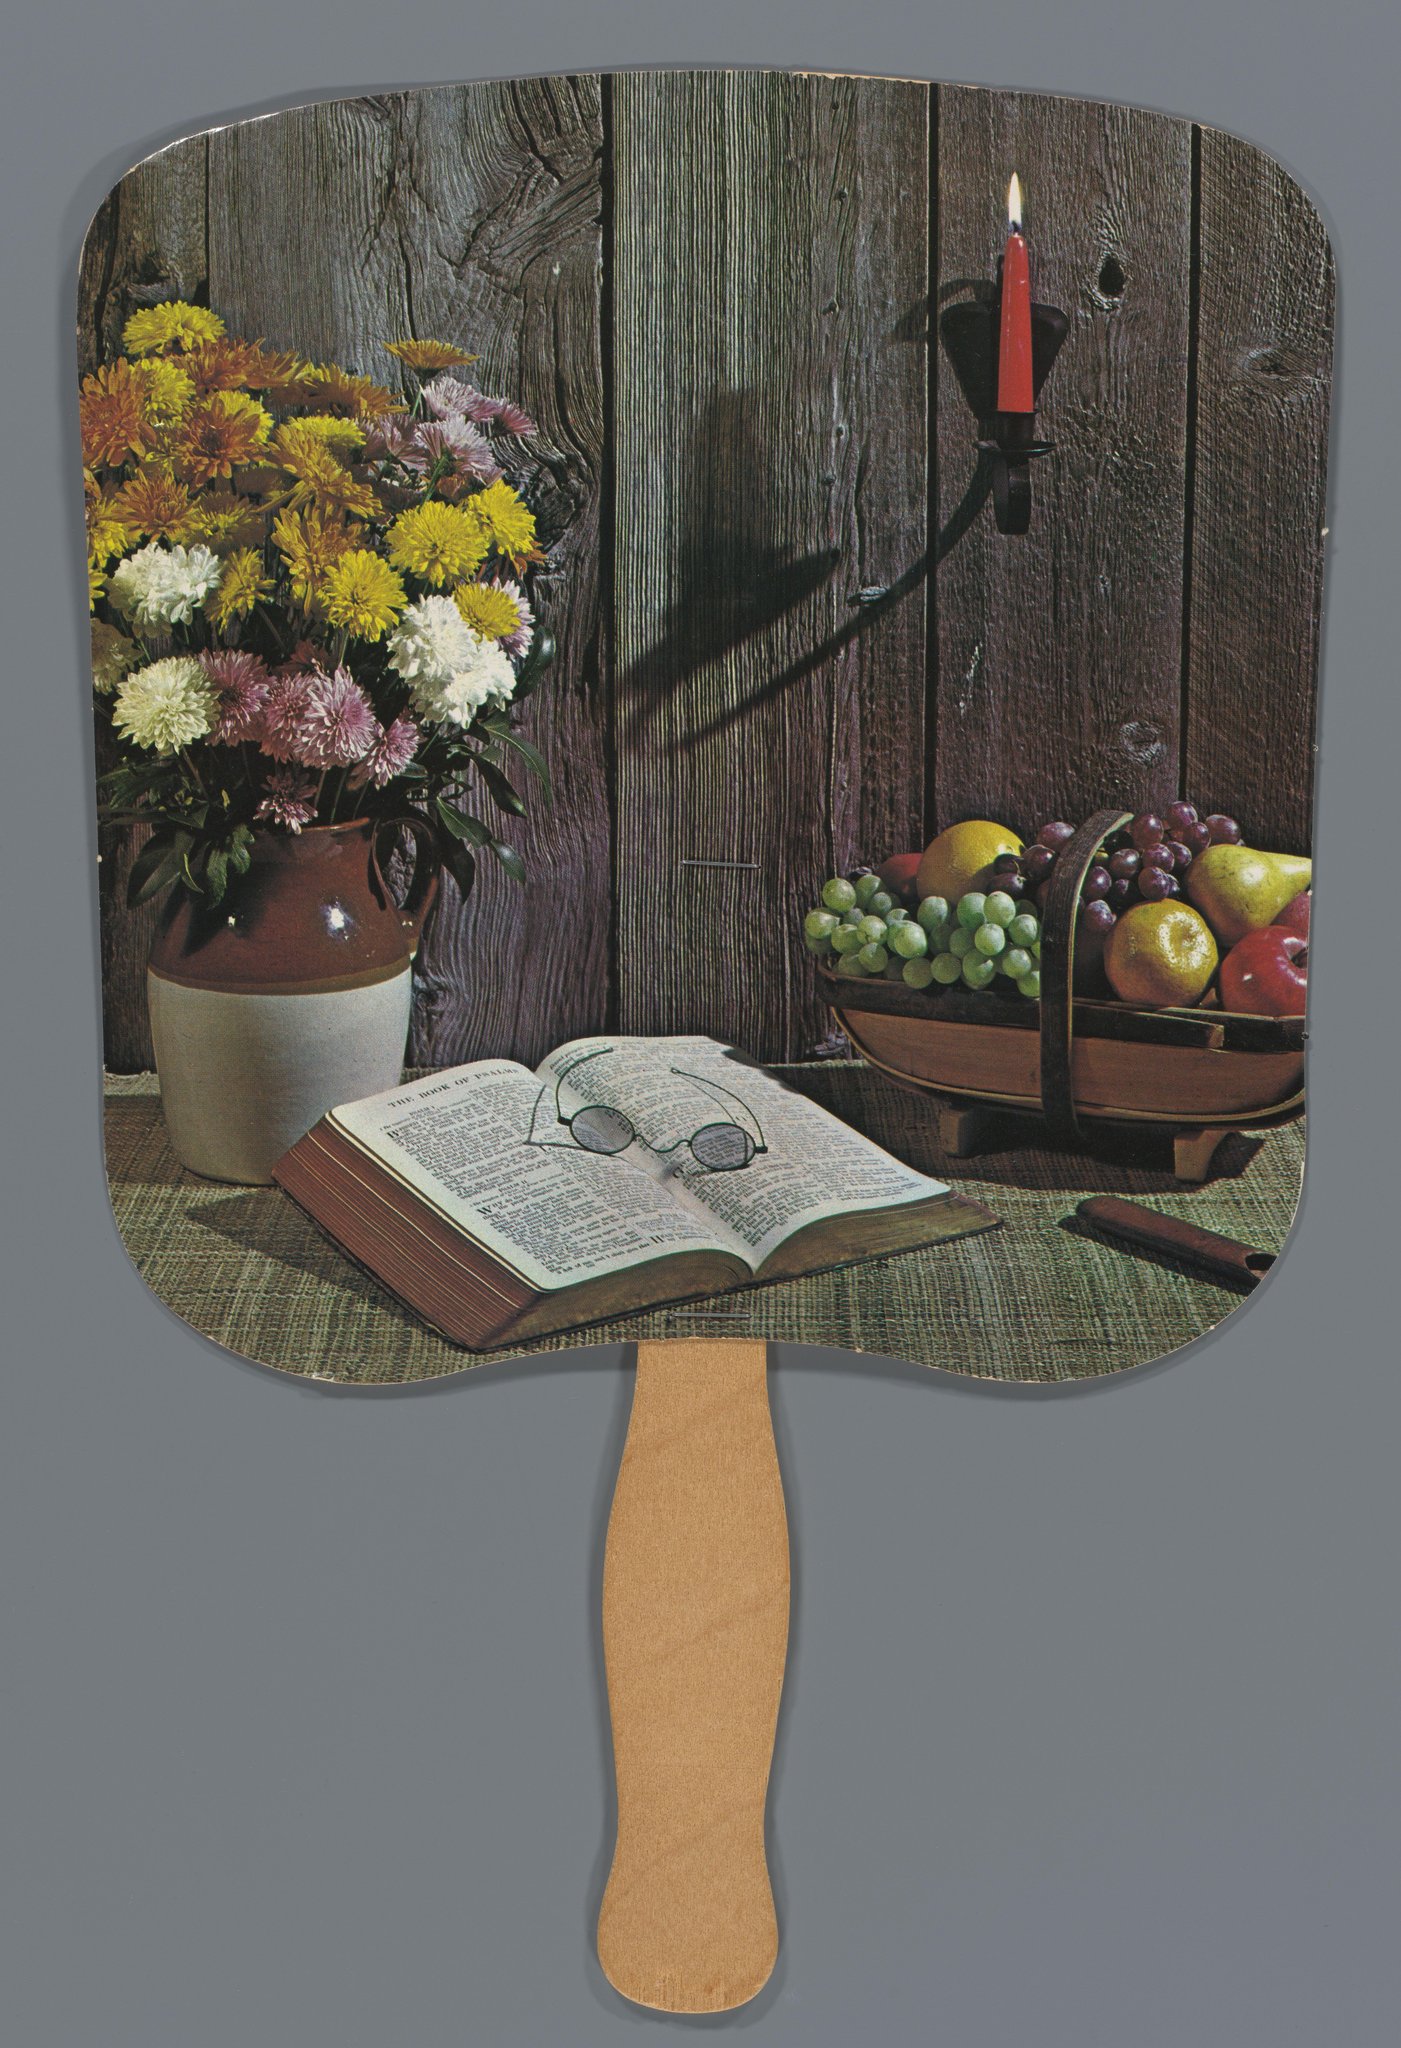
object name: fan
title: Kerkwaaier met foto van stilleven met bijbel en op de keerzijde een reclametekst voor Life Insurance Company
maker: Anonymous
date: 1960-1975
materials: paper, wood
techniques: offset printed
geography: united states